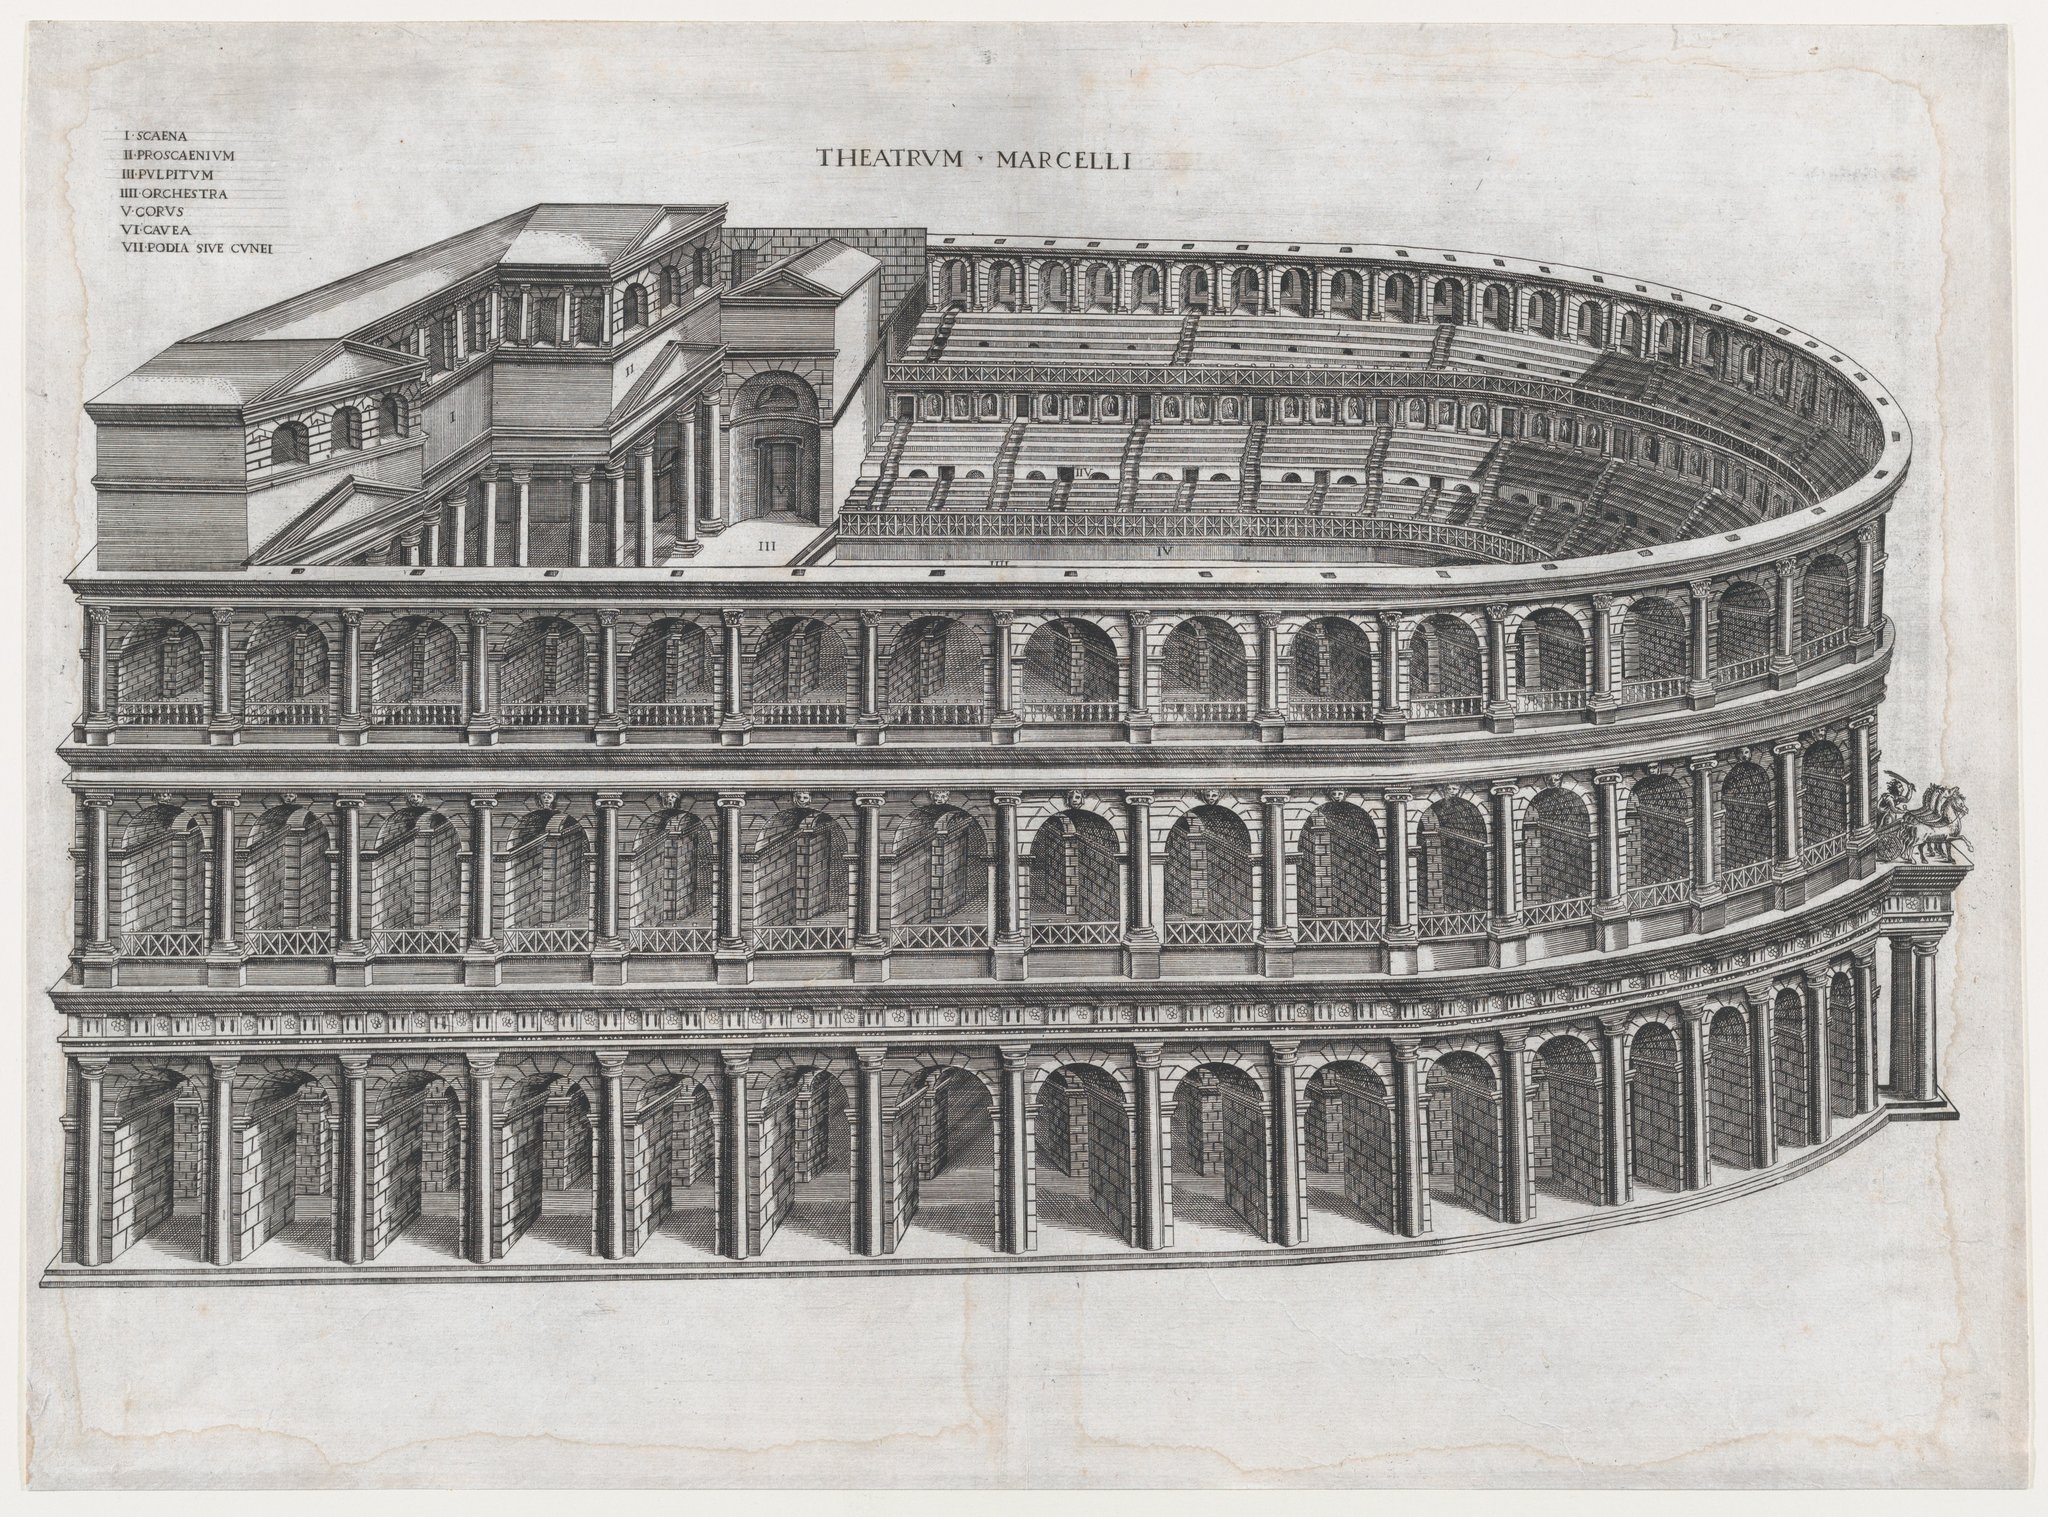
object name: print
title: Theater of Marcellus, from "Speculum Romanae Magnificentiae"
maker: Anonymous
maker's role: artist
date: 1501-1600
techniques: engraving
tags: buildings,rome